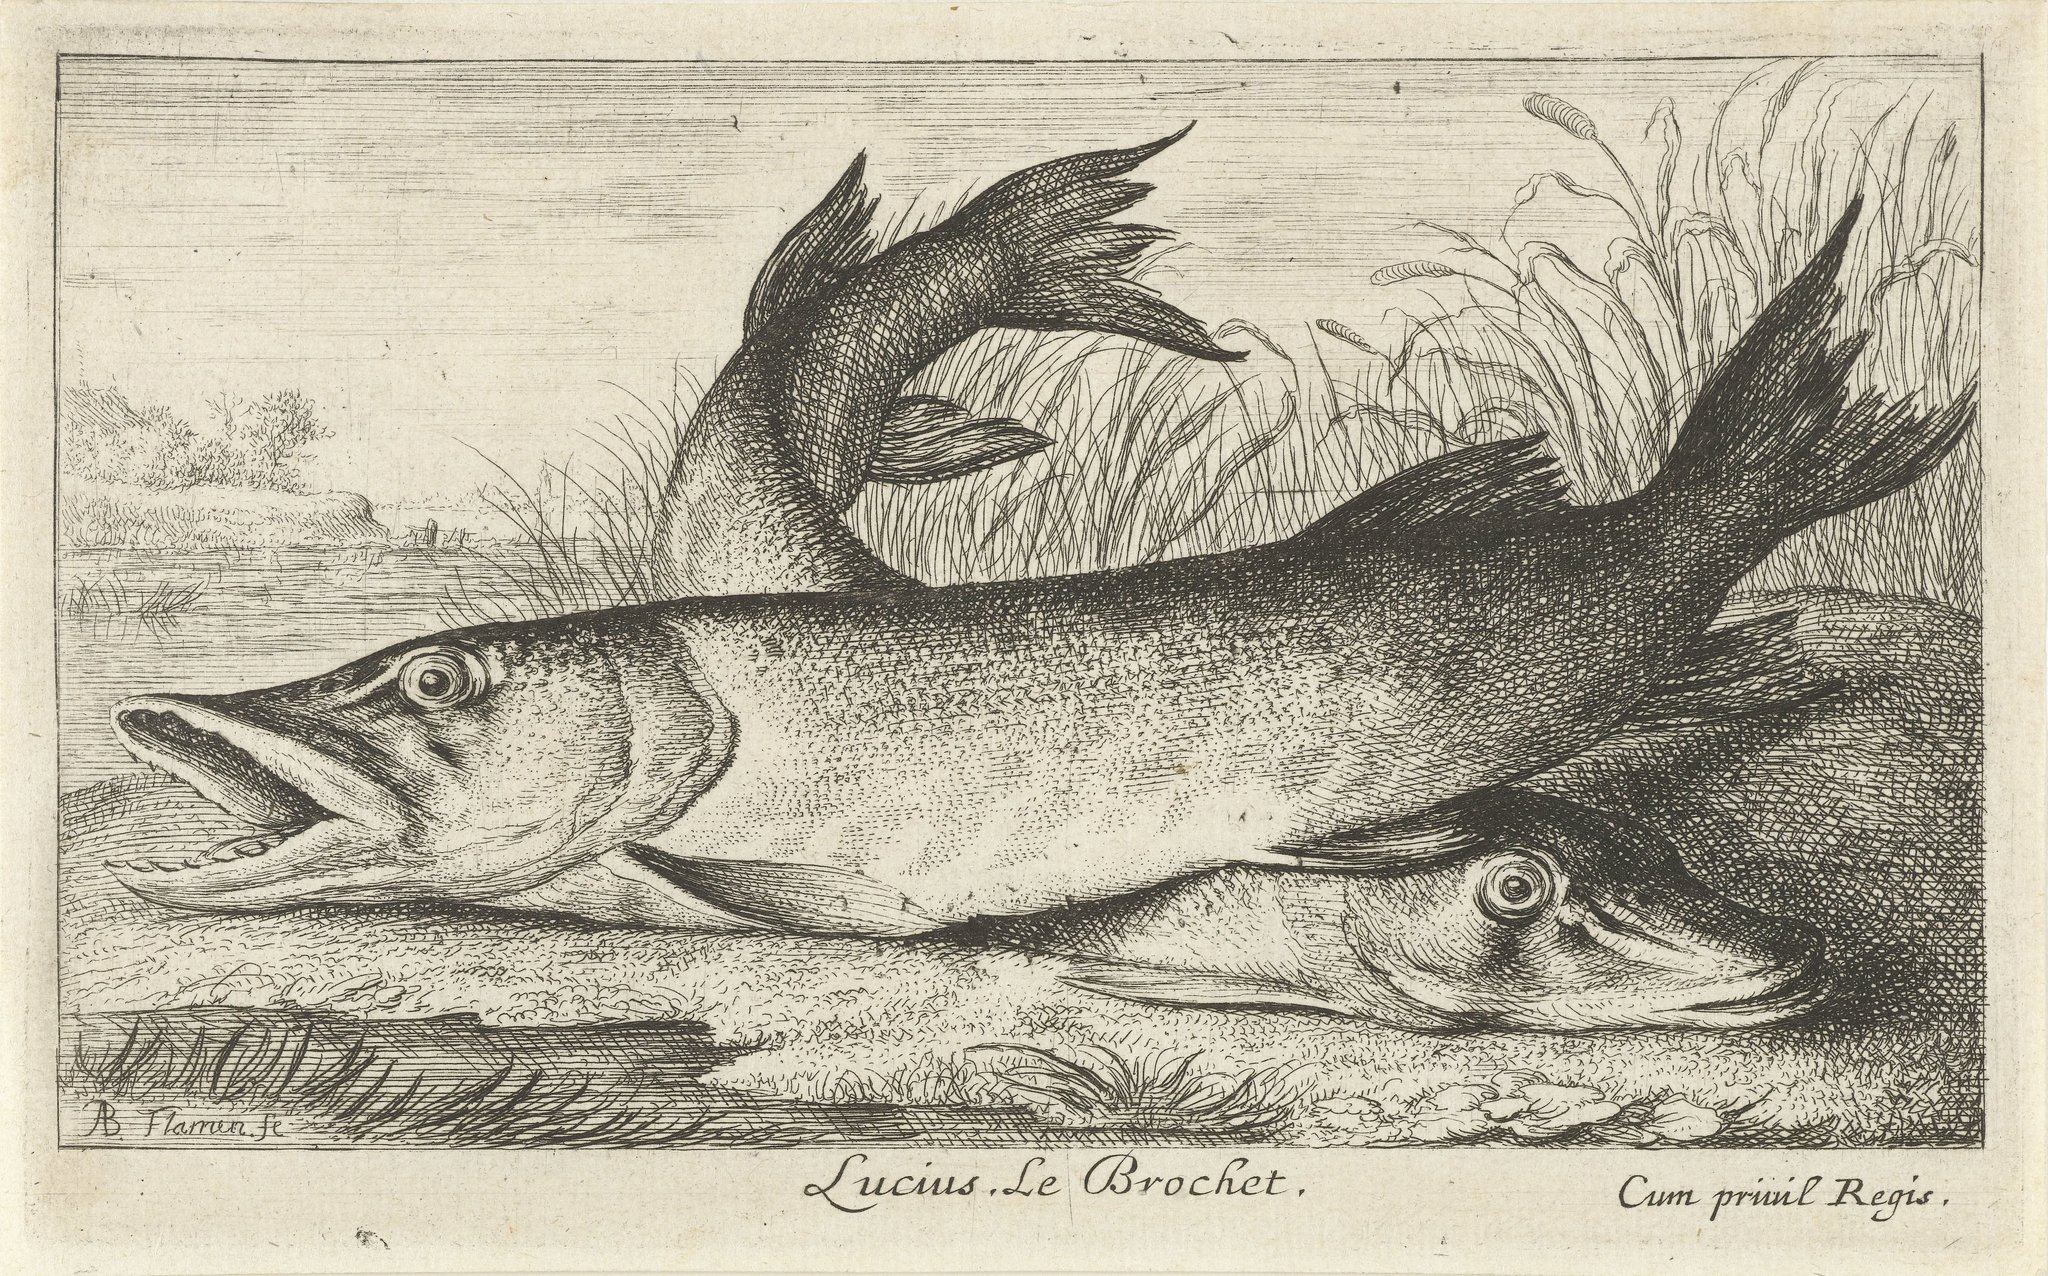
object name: print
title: Lucius. Le Brochet.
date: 1664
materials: paper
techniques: etching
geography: paris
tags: bony fishes: pike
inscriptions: collector's mark: Lugt 2228